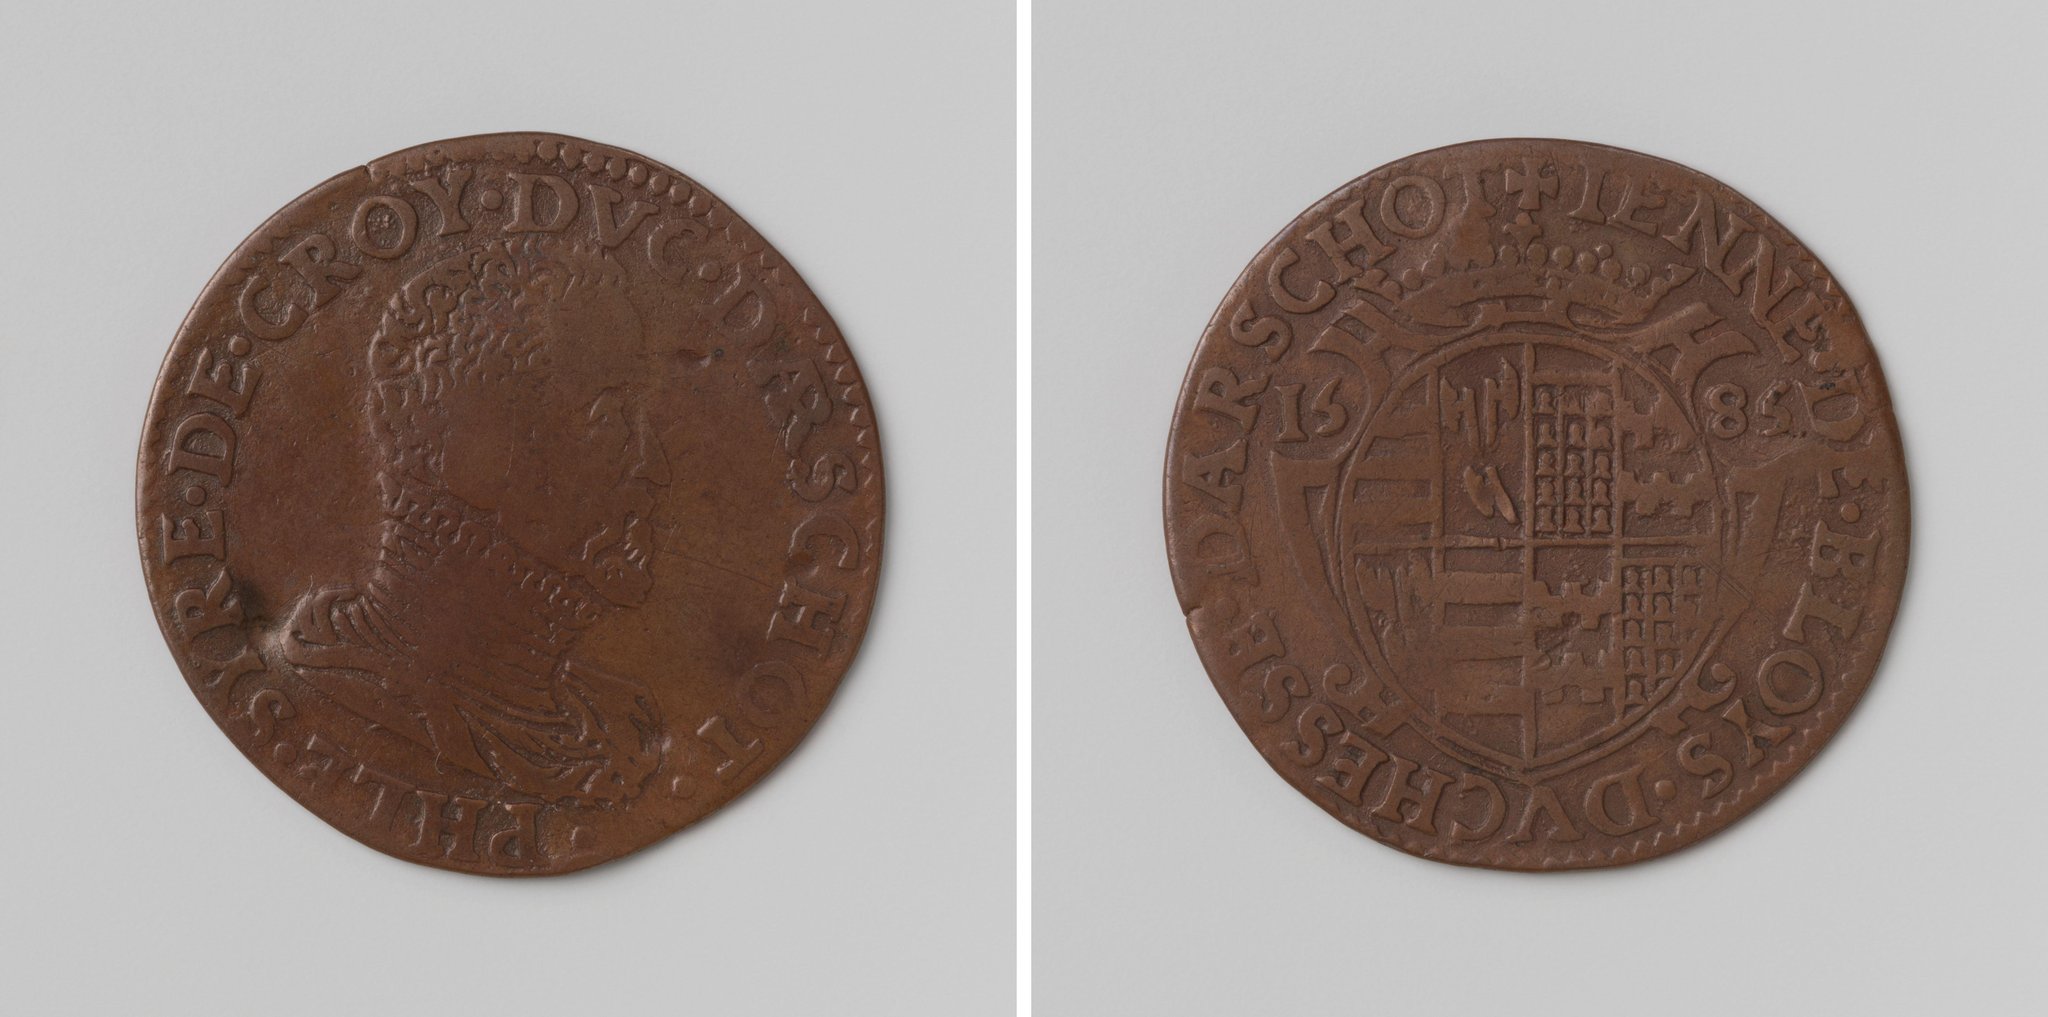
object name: jeton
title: Filips III van Croy, hertog van Aarschot en Johanna van Blois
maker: Anonymous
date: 1585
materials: copper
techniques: striking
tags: venice, earl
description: Koperen penning. Voorzijde: borststuk man binnen omschrift. Keerzijde: wapenschild in cartouche tussen jaartal onder kroon binnen omschrift